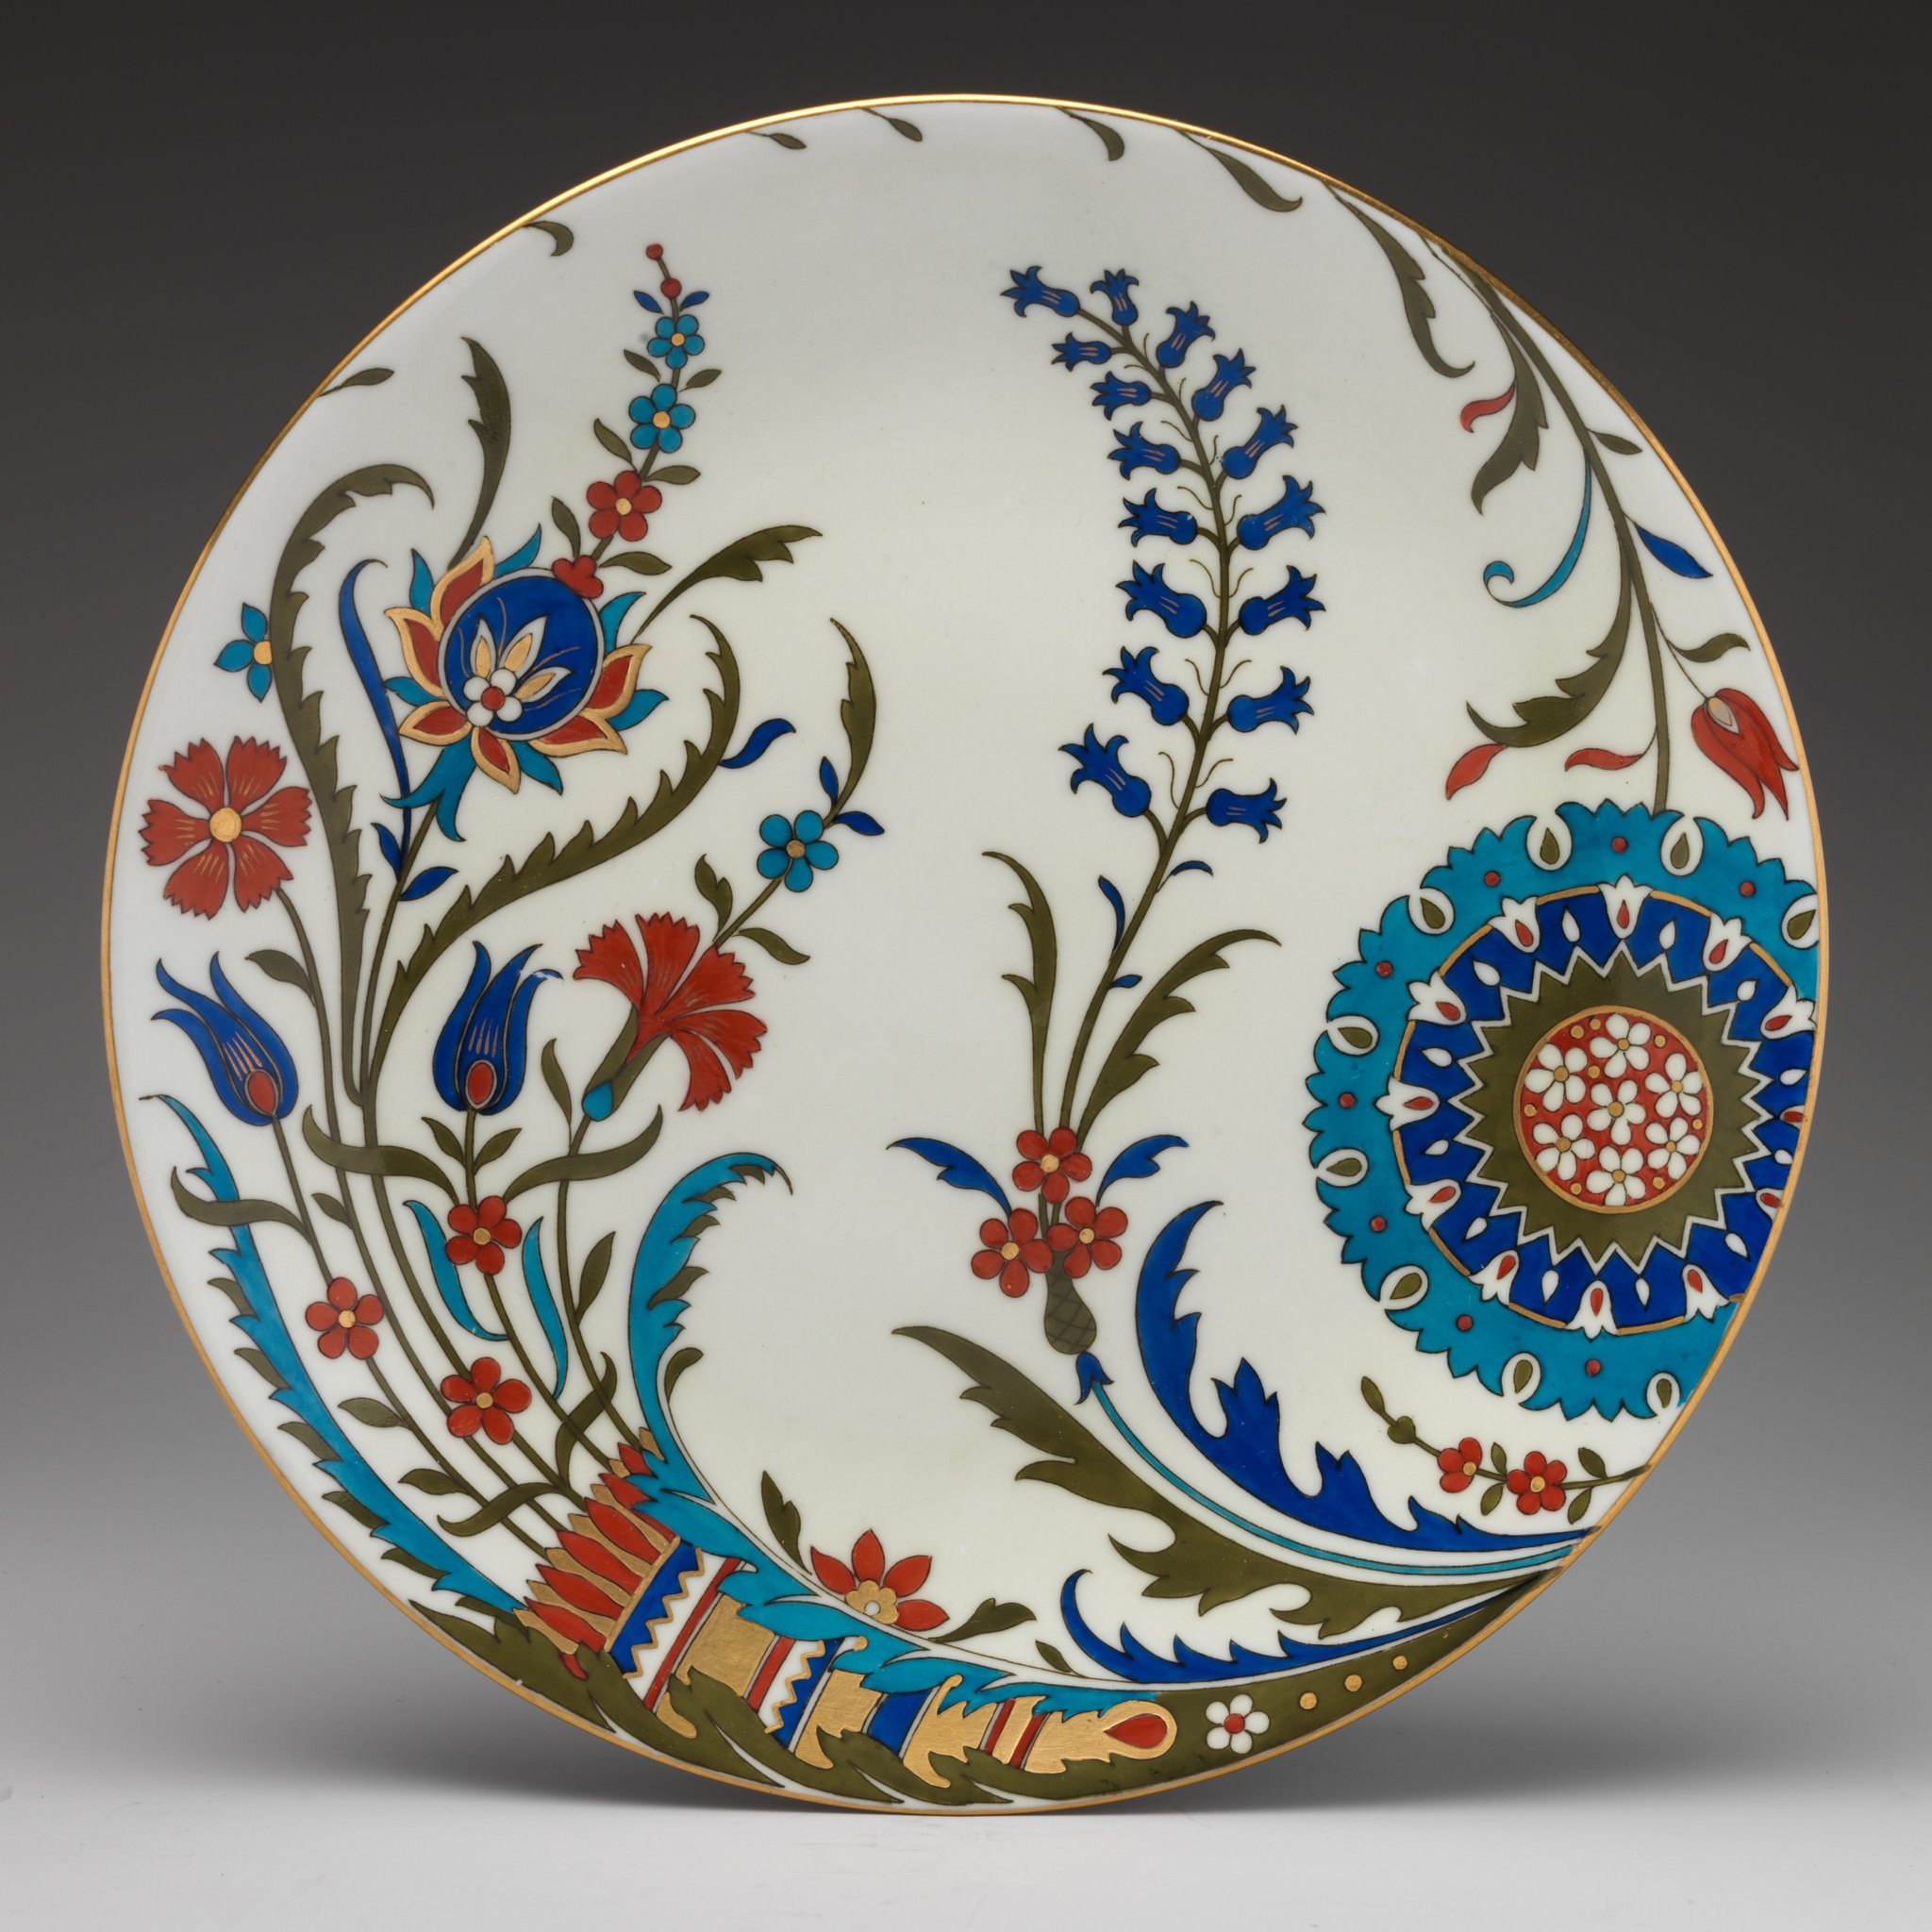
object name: plate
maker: minton(s)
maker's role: maker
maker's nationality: british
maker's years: 1793-2001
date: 1880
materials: bone china